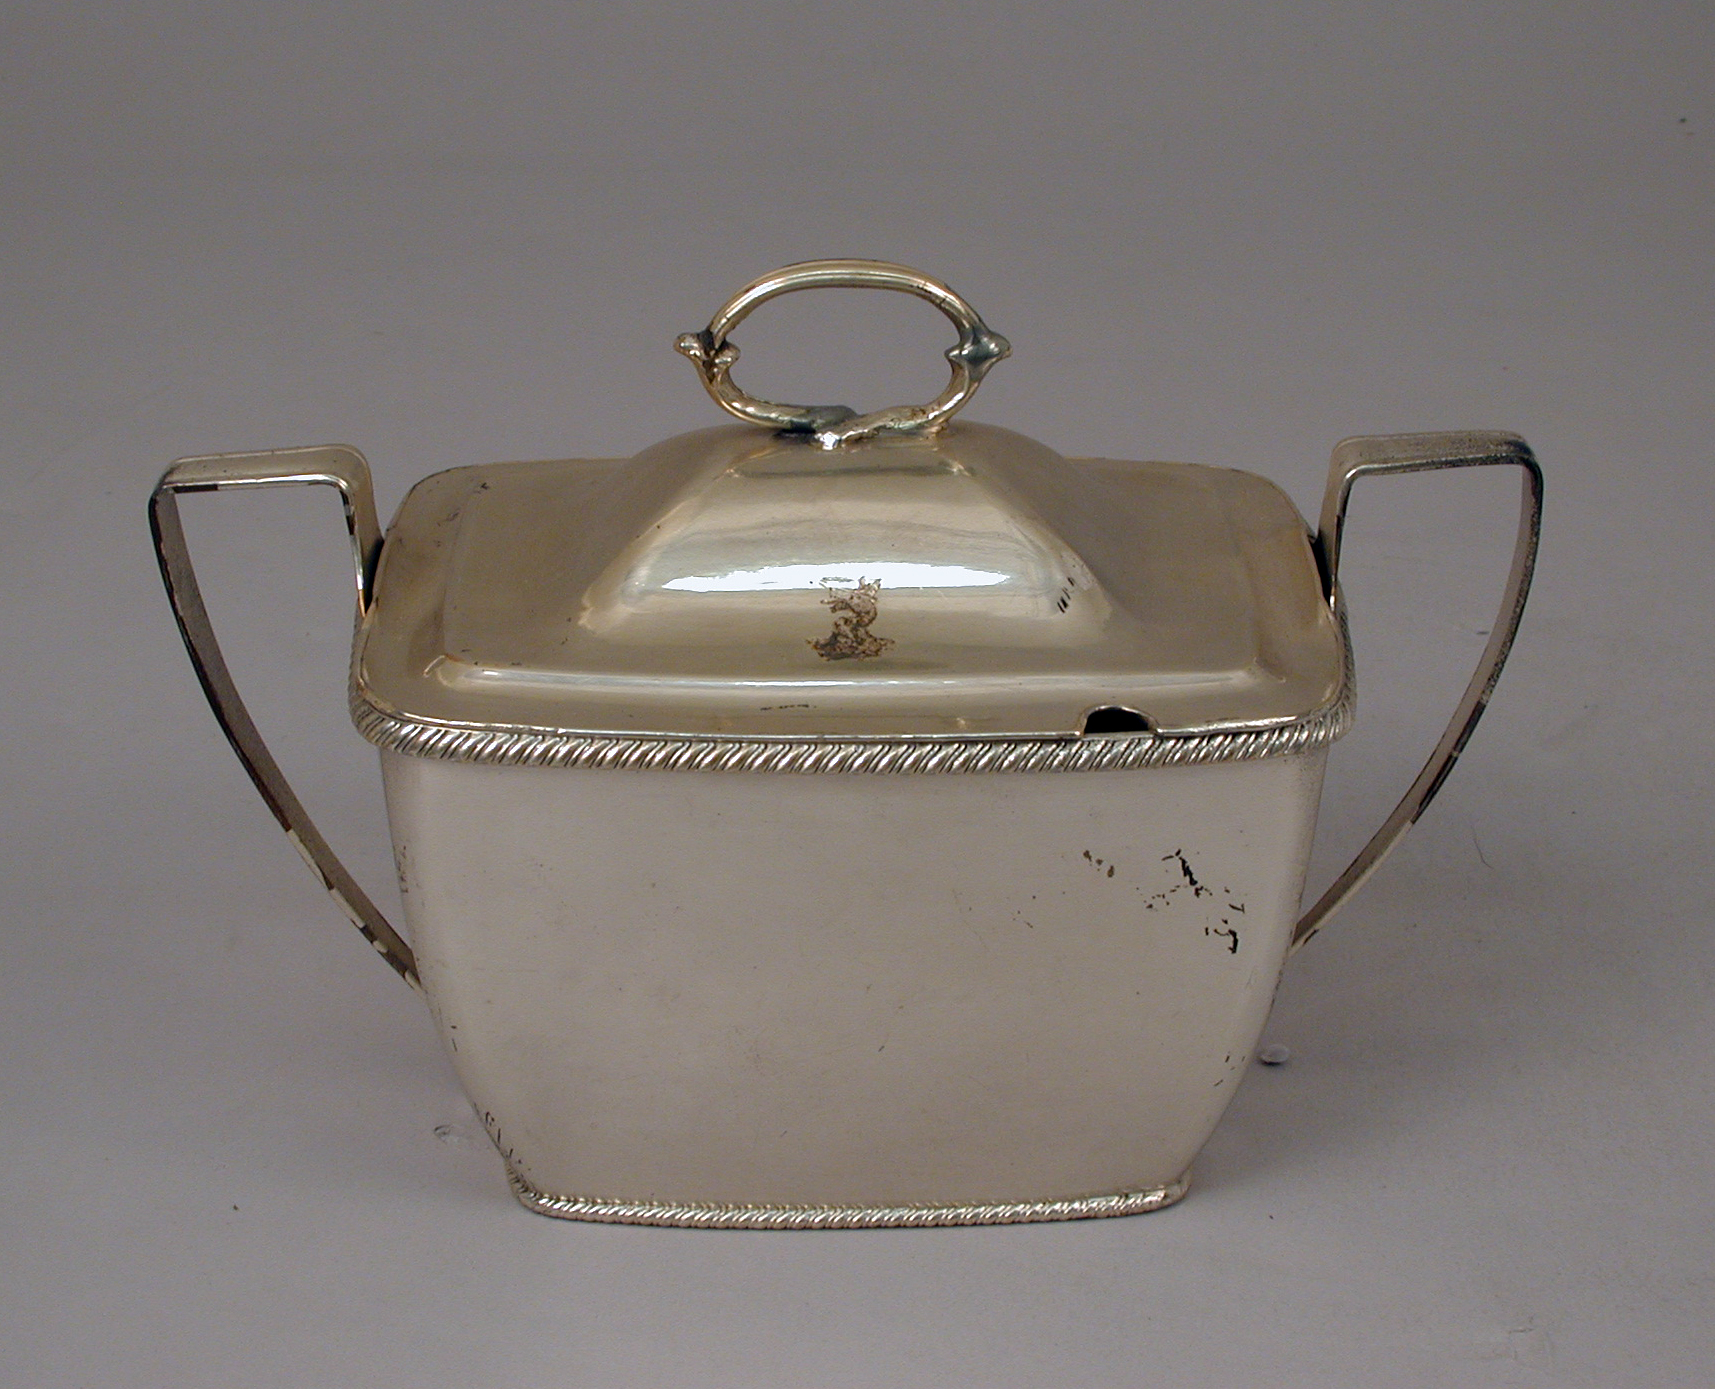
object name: sauce tureen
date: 1800-1805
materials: metal